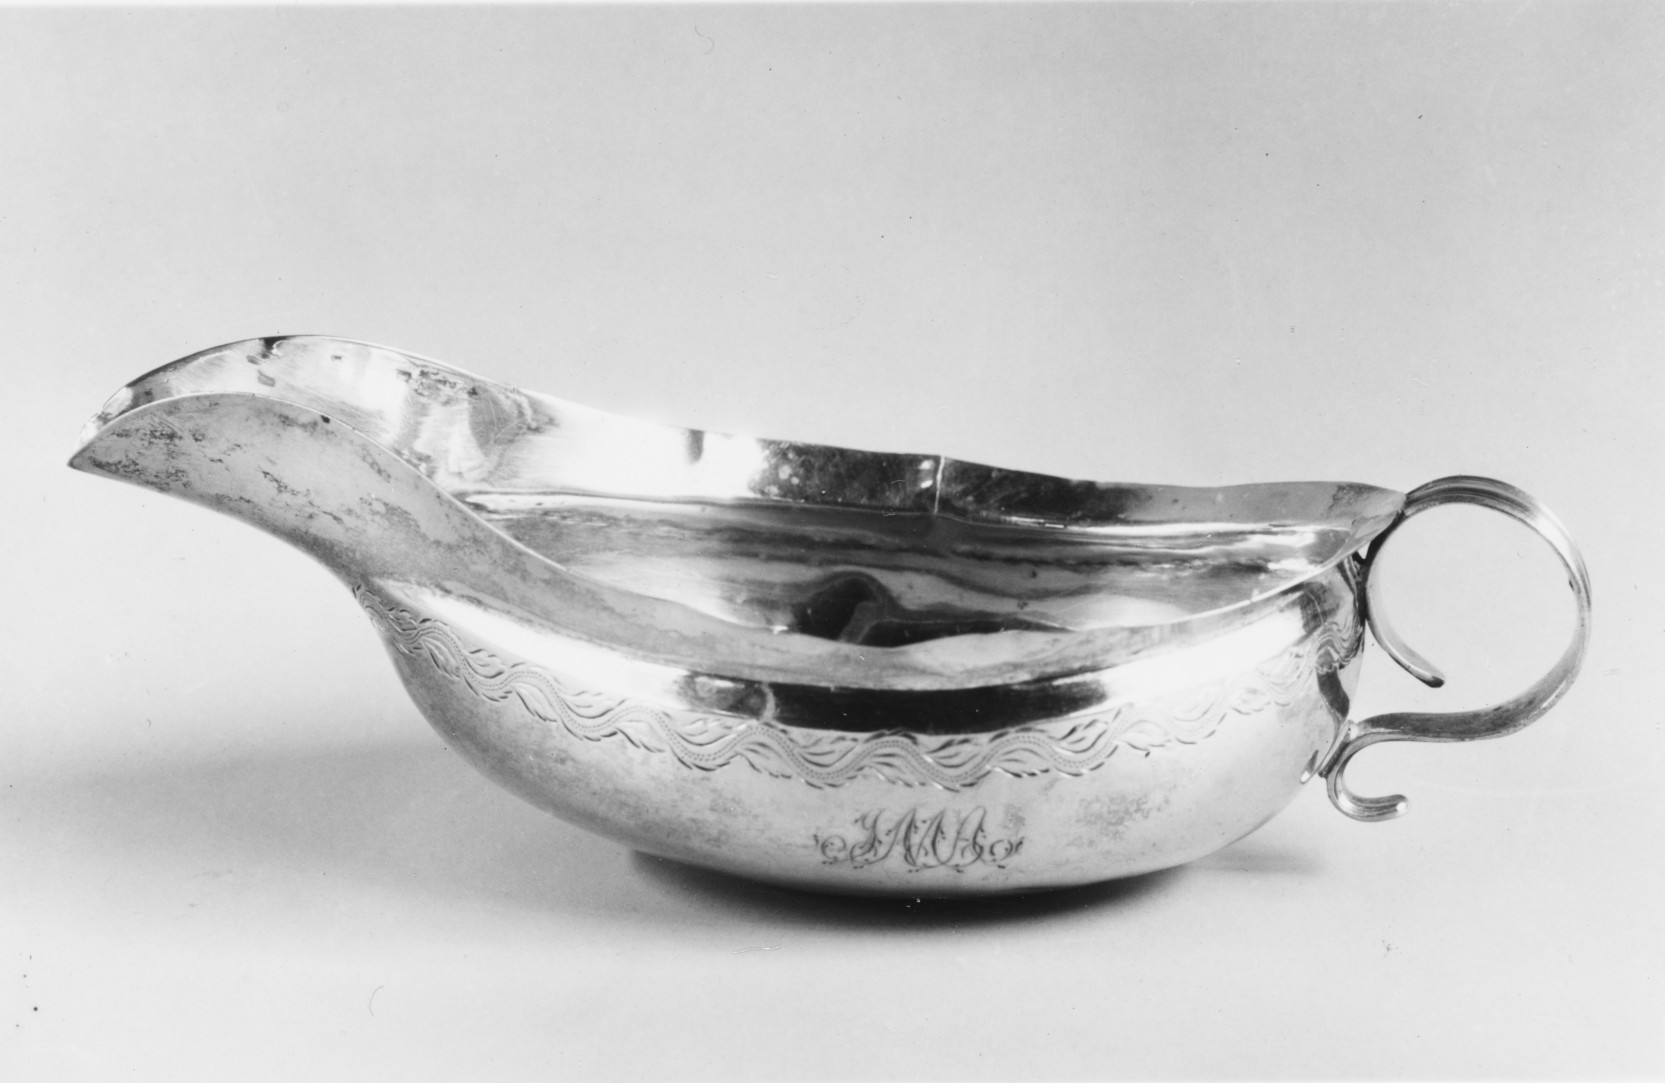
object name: pap boat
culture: american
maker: william thomson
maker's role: maker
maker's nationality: american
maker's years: 1777-1833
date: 1810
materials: silver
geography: united states